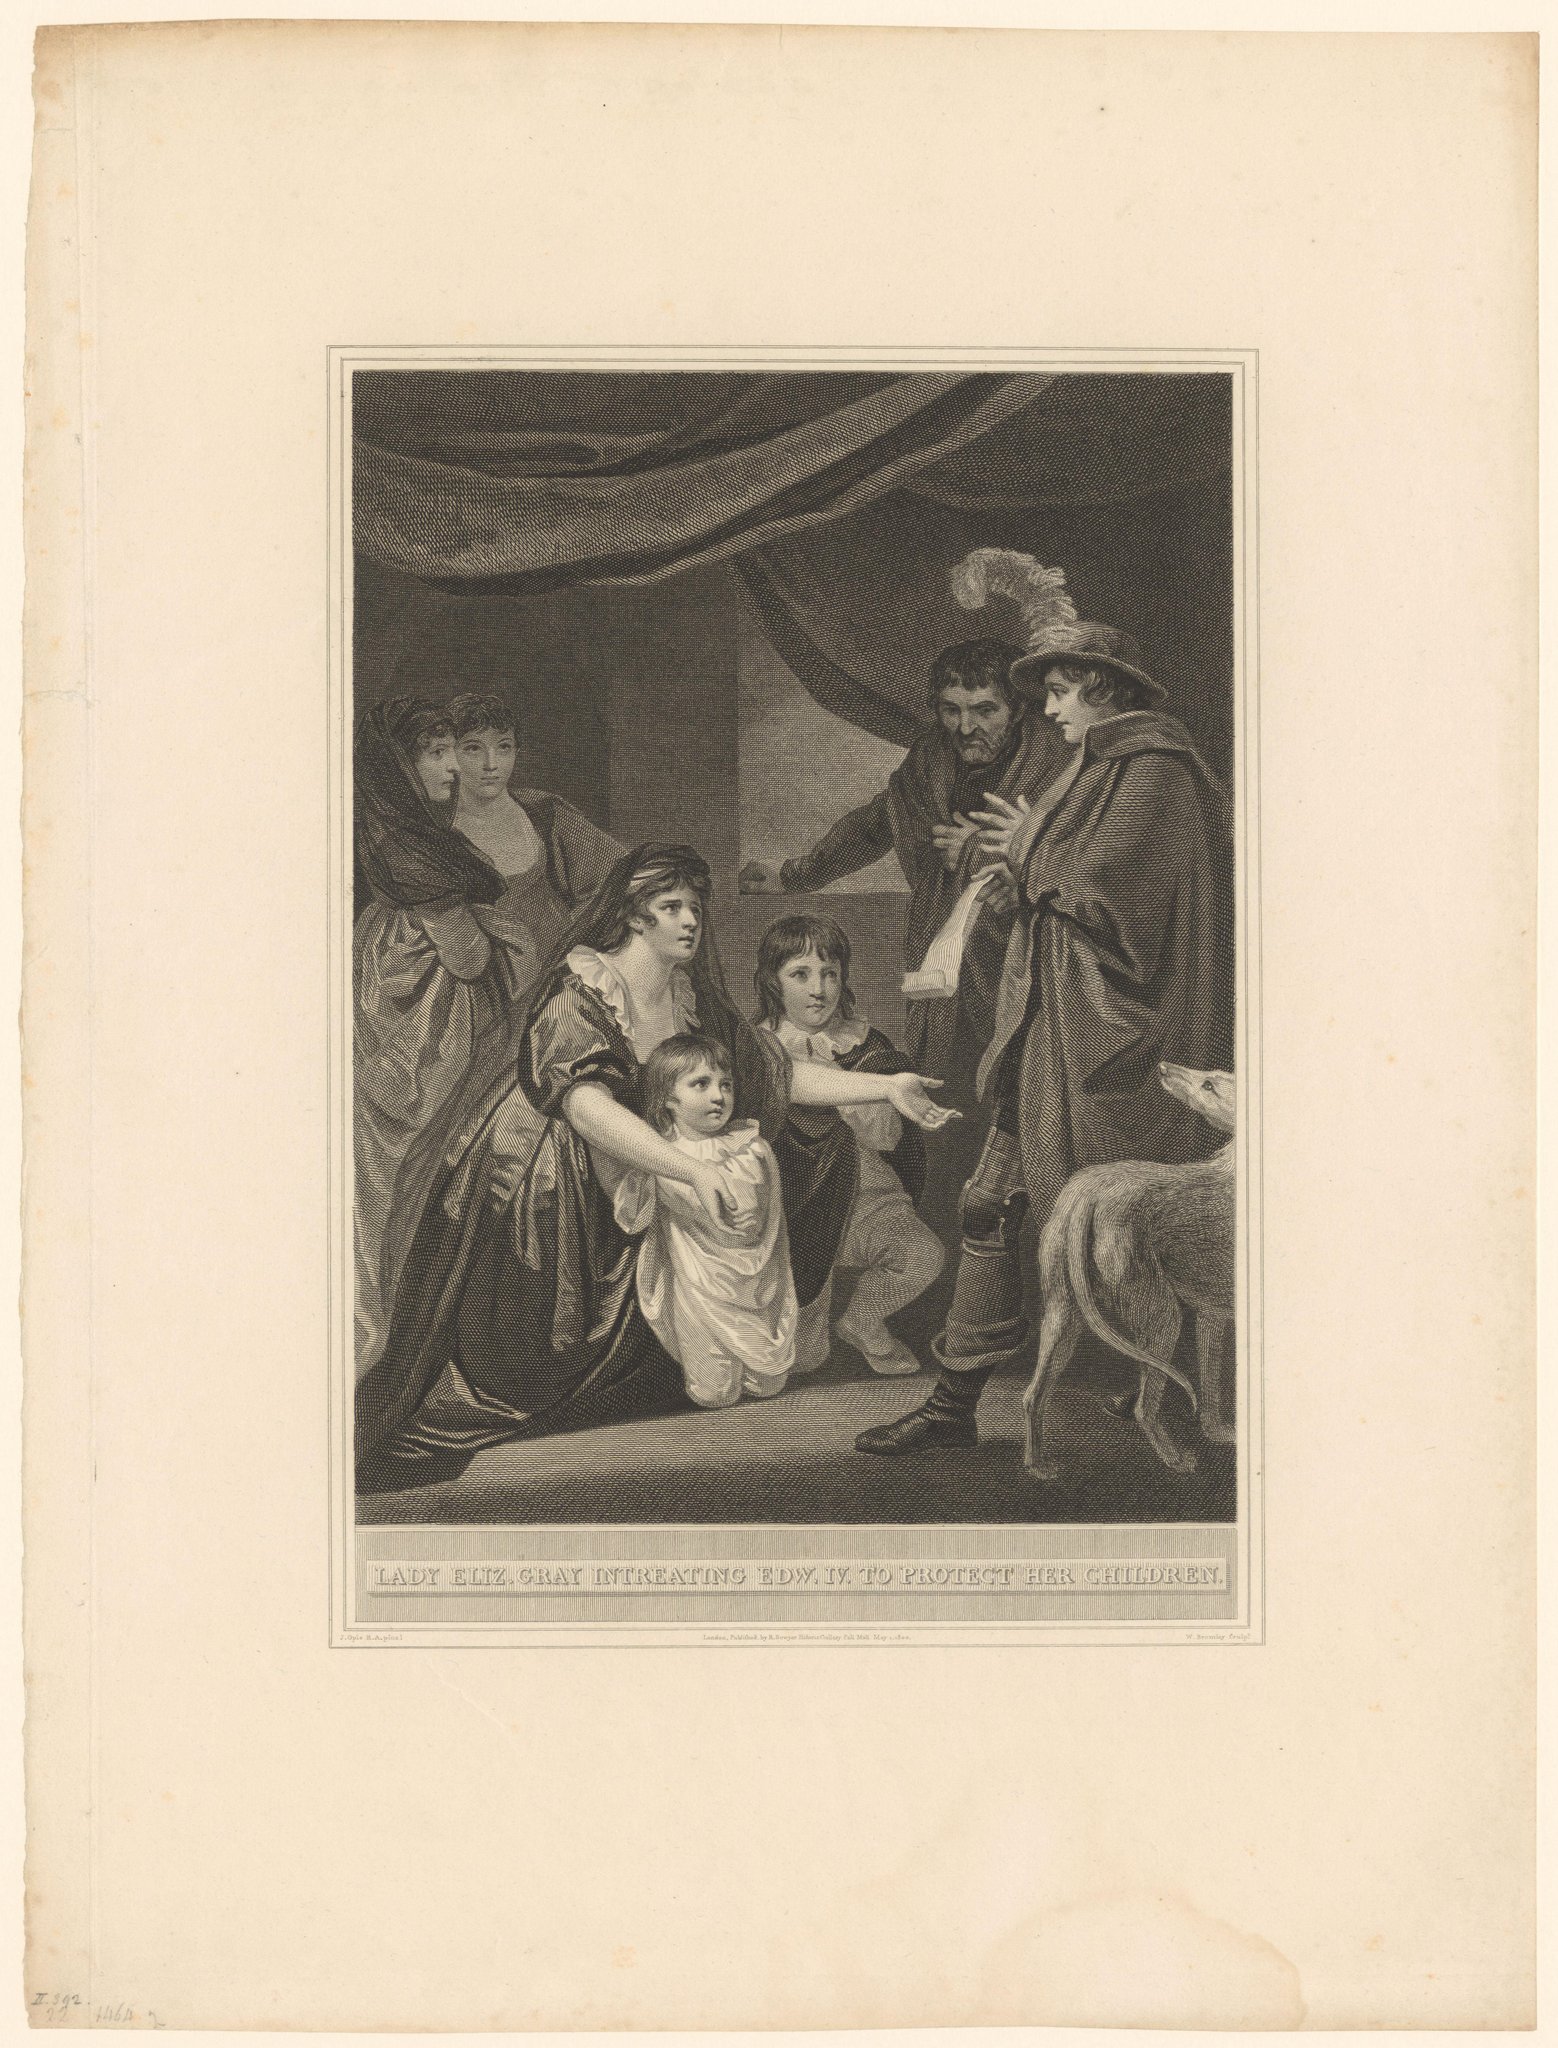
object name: book illustration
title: Lady Eliz. Gray intreating Edw. IV to protect her children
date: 1800-1805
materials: paper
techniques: engraving, etching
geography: london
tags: london, mother and son(s) (family group), king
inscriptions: collector's mark: Lugt 2228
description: Prent uit: Hume, David. The History of England. Londen: Robert Bowyer, 1800.